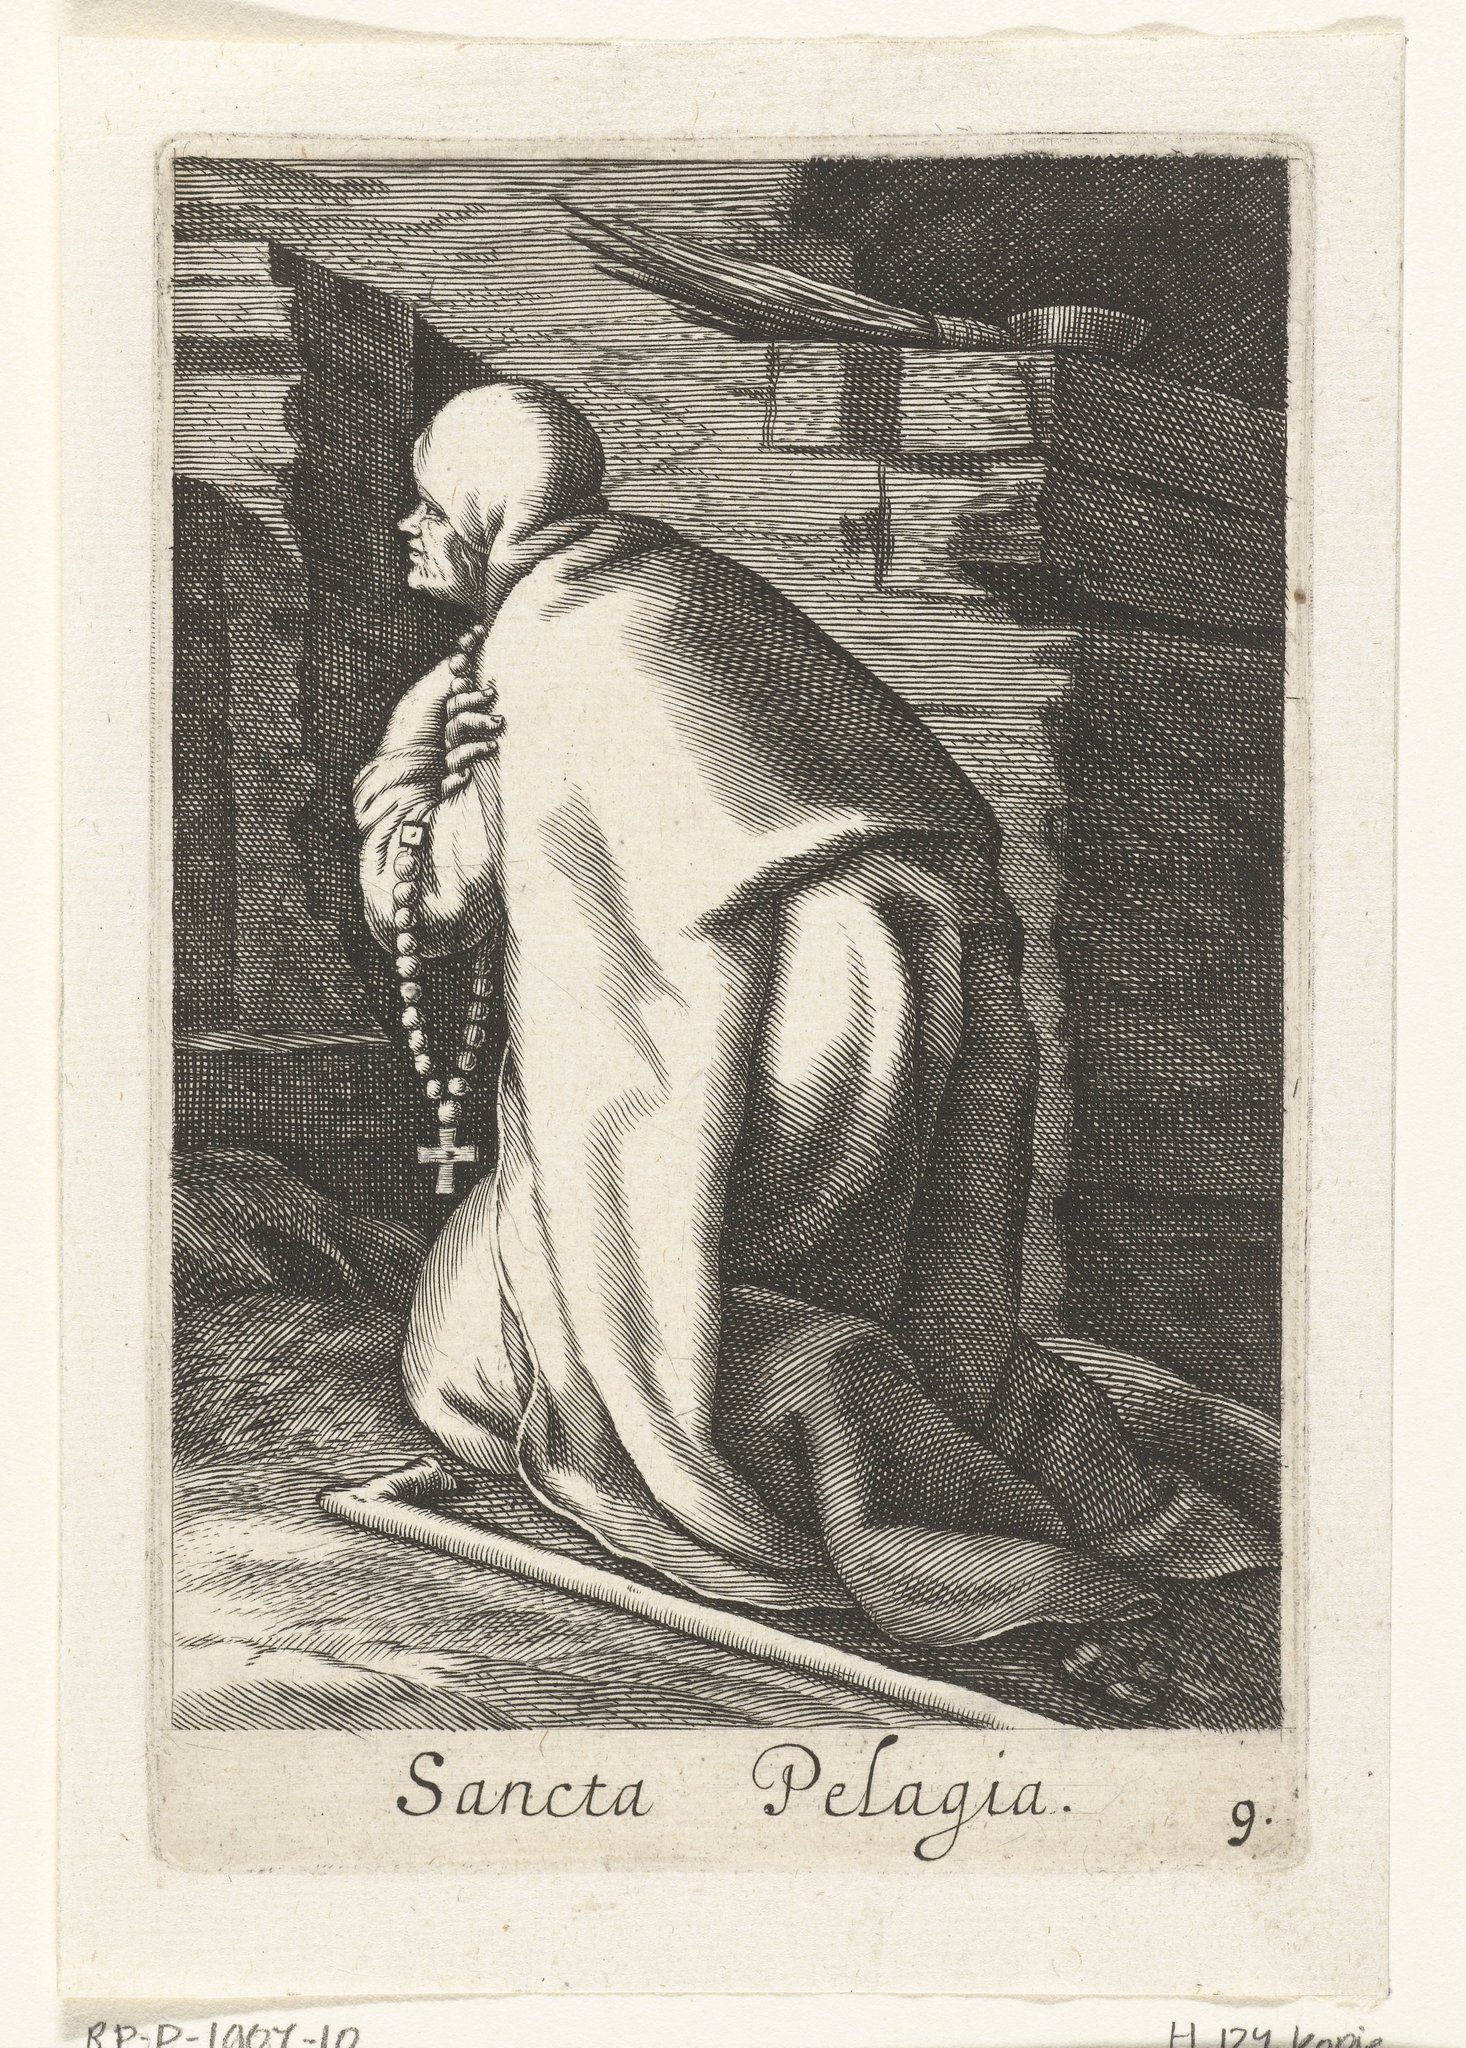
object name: print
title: Sancta Pelagia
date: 1590-1662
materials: paper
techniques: engraving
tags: anchorite, hermit, female saints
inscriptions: collector's mark: Lugt 2228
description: Kopie in spiegelbeeld naar prent van Boëtius Adamsz. Bolswert uit serie Kluizenaressen.